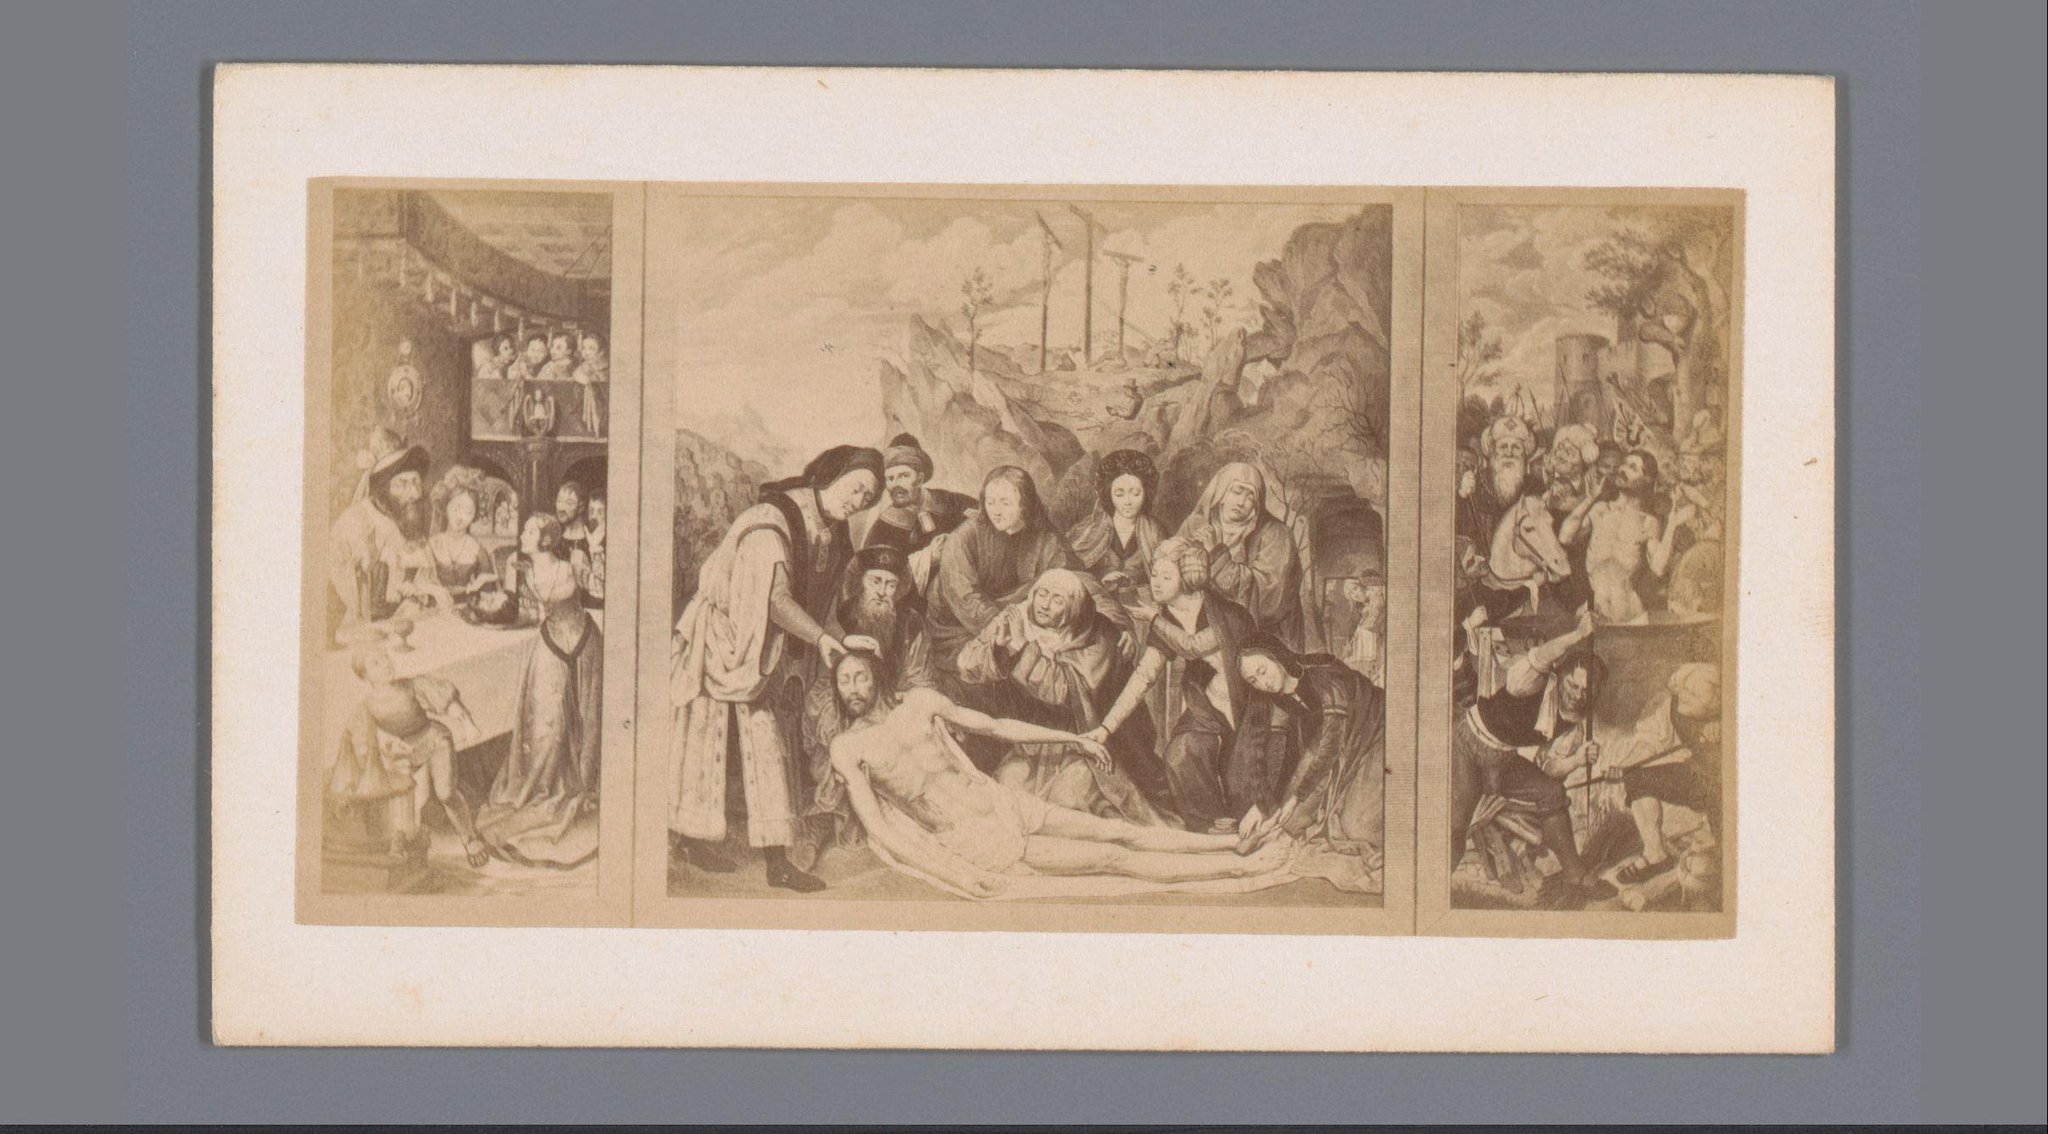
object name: carte de visite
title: Quentin Massys. Ensevelissement du Christ. Musée d'Anvers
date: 1858-1866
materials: cardboard, paper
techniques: albumen print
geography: antwerp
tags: lamentation over the dead christ by his relatives and friends (christ usually without crown of thorns)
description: Het altaarstuk van Massijs bevindt zich in het Museum voor Schone Kunsten te Antwerpen.